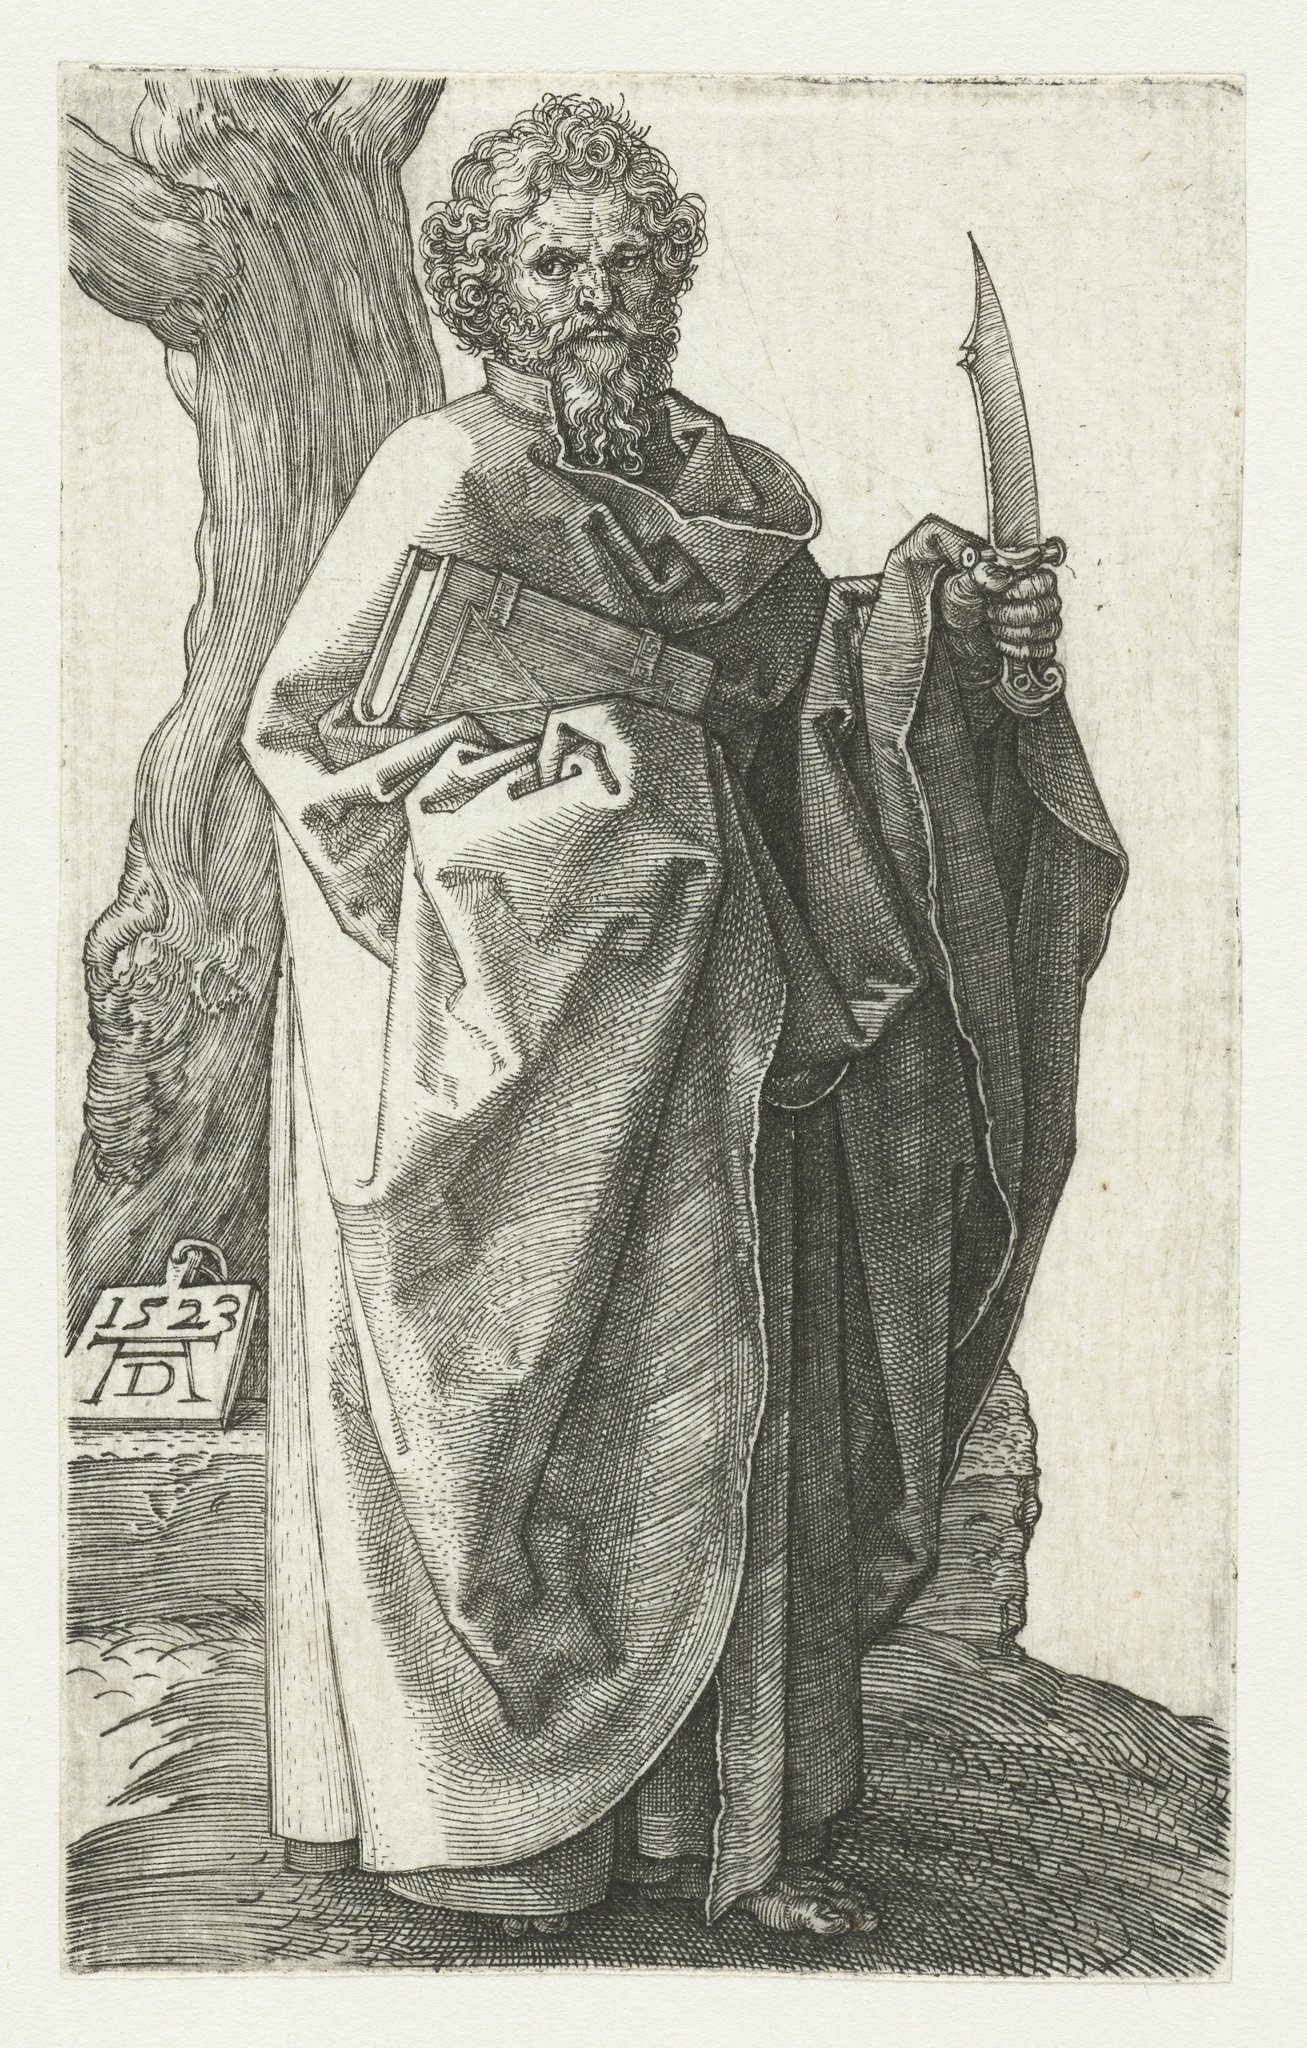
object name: print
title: De apostelen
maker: albrecht dürer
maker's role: draughtsman, painter, print maker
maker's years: 1471-1528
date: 1523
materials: paper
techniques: engraving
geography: nuremberg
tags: the apostle bartholomew; possible attributes: book, devil or dragon at feet, knife, scroll, flayed skin, staff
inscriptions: collector's mark: Lugt 2228a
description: De apostel Bartholomeus, ten voeten uit, met een mes en een boek in de handen. Deze prent is onderdeel van een (onvoltooide, want vijfdelige) serie van de twaalf apostelen.